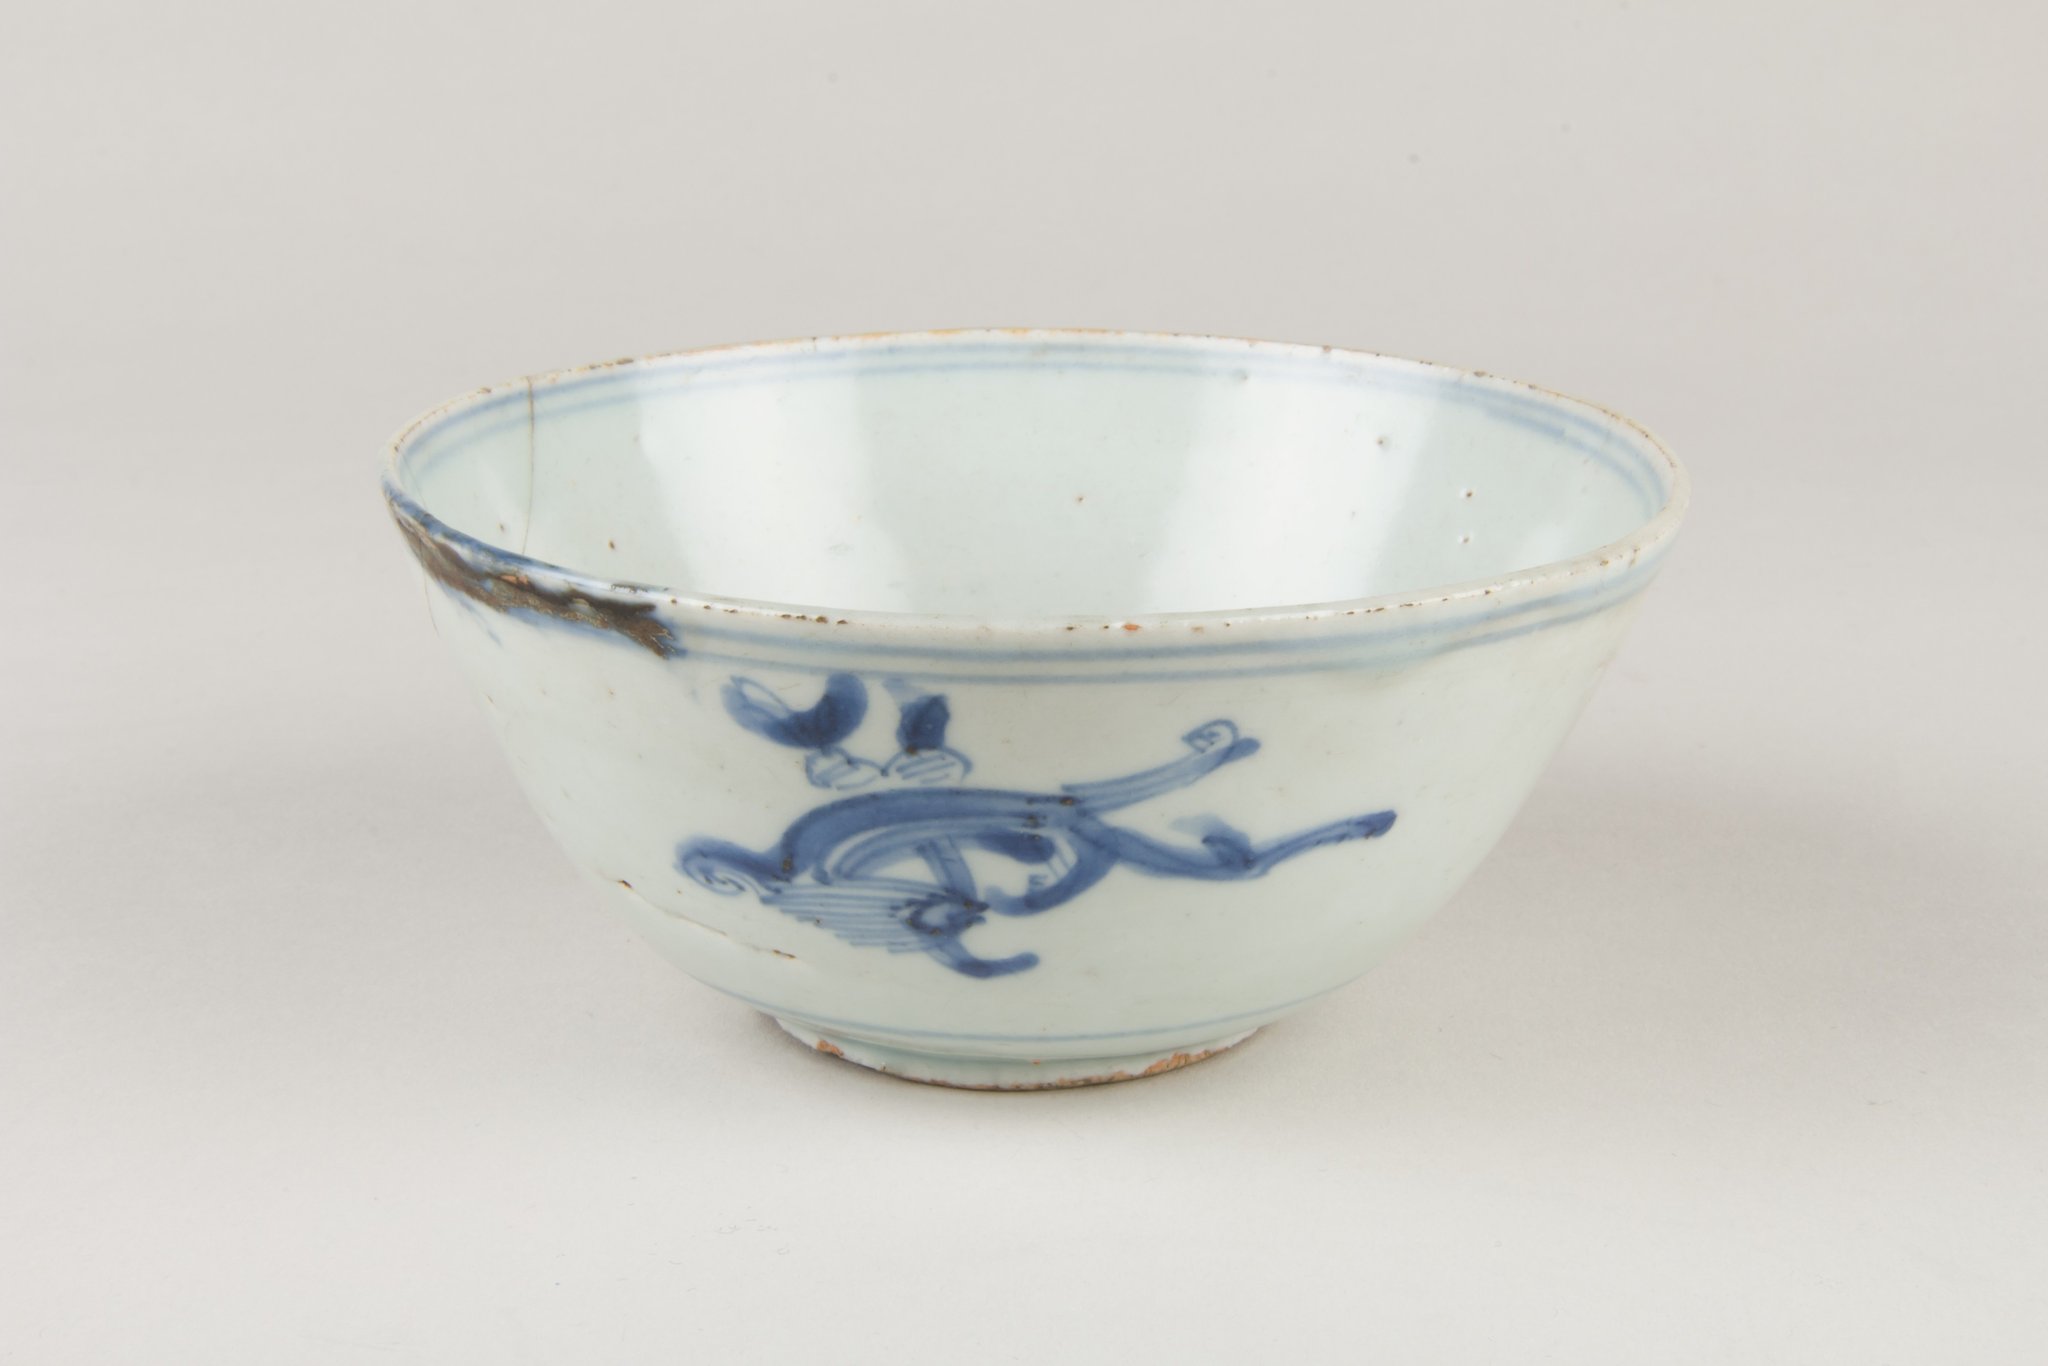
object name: bowl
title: Bowl with dragon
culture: chinese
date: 1567-1633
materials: cobalt, porcelain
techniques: painting, underglaze